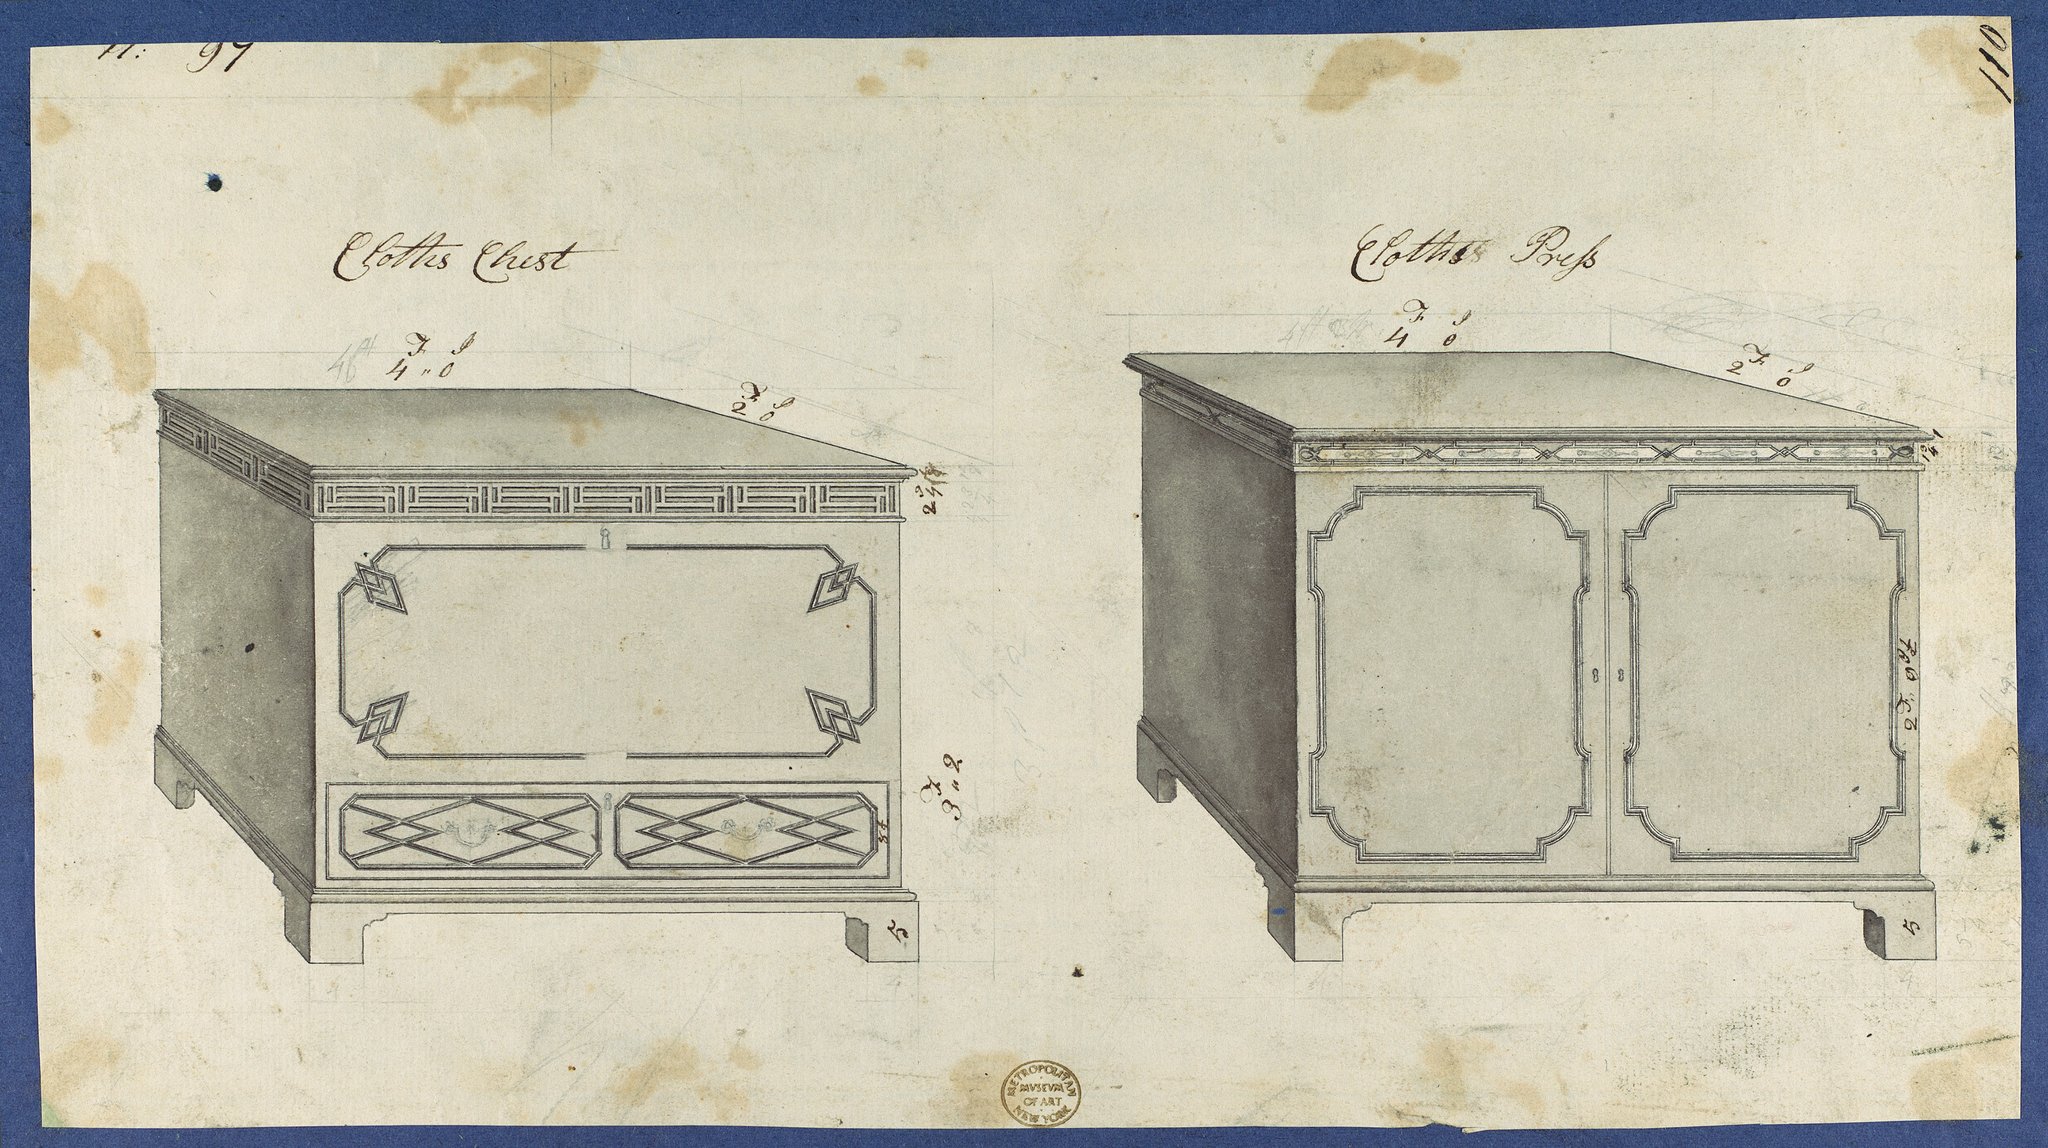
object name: drawing ornament architecture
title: Clothes Chest and Clothes Press, from Chippendale Drawings, Vol. II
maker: thomas chippendale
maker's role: artist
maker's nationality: british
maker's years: 1718-1779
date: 1753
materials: ink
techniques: brush, pen, wash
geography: london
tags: chests